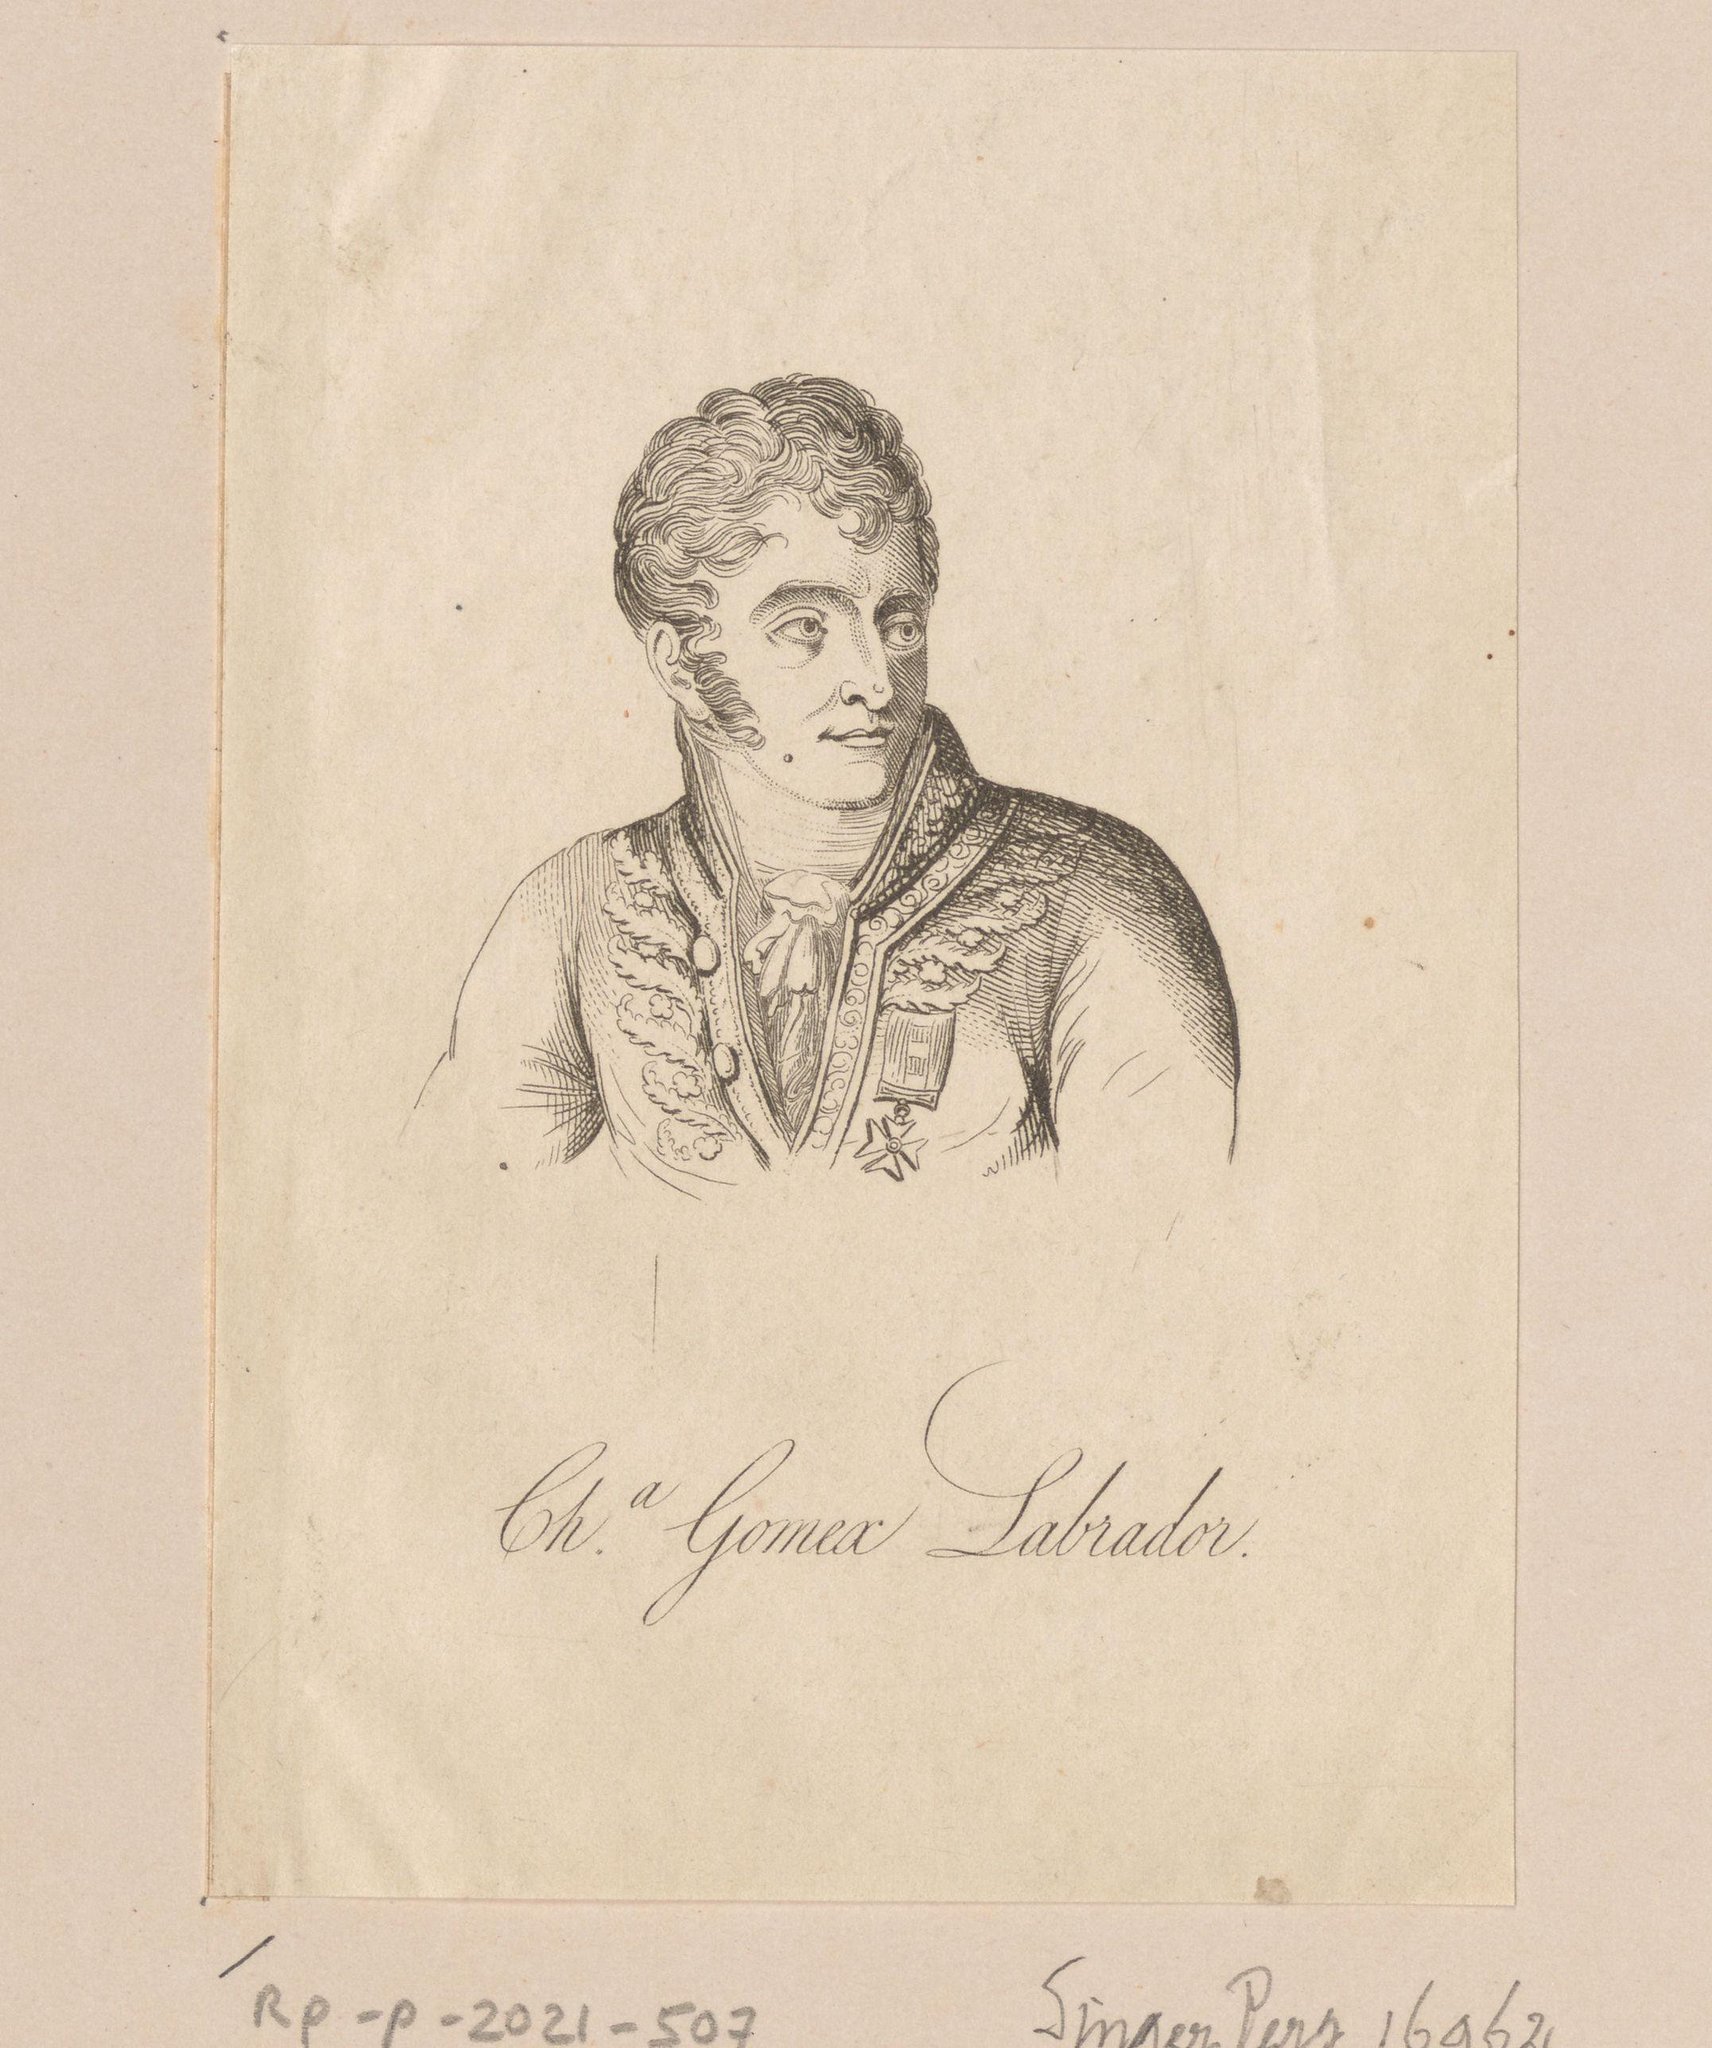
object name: print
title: Portret van Pedro Gómez Labrador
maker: Anonymous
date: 1800-1850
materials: paper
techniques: etching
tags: historical persons, diplomacy, diplomat